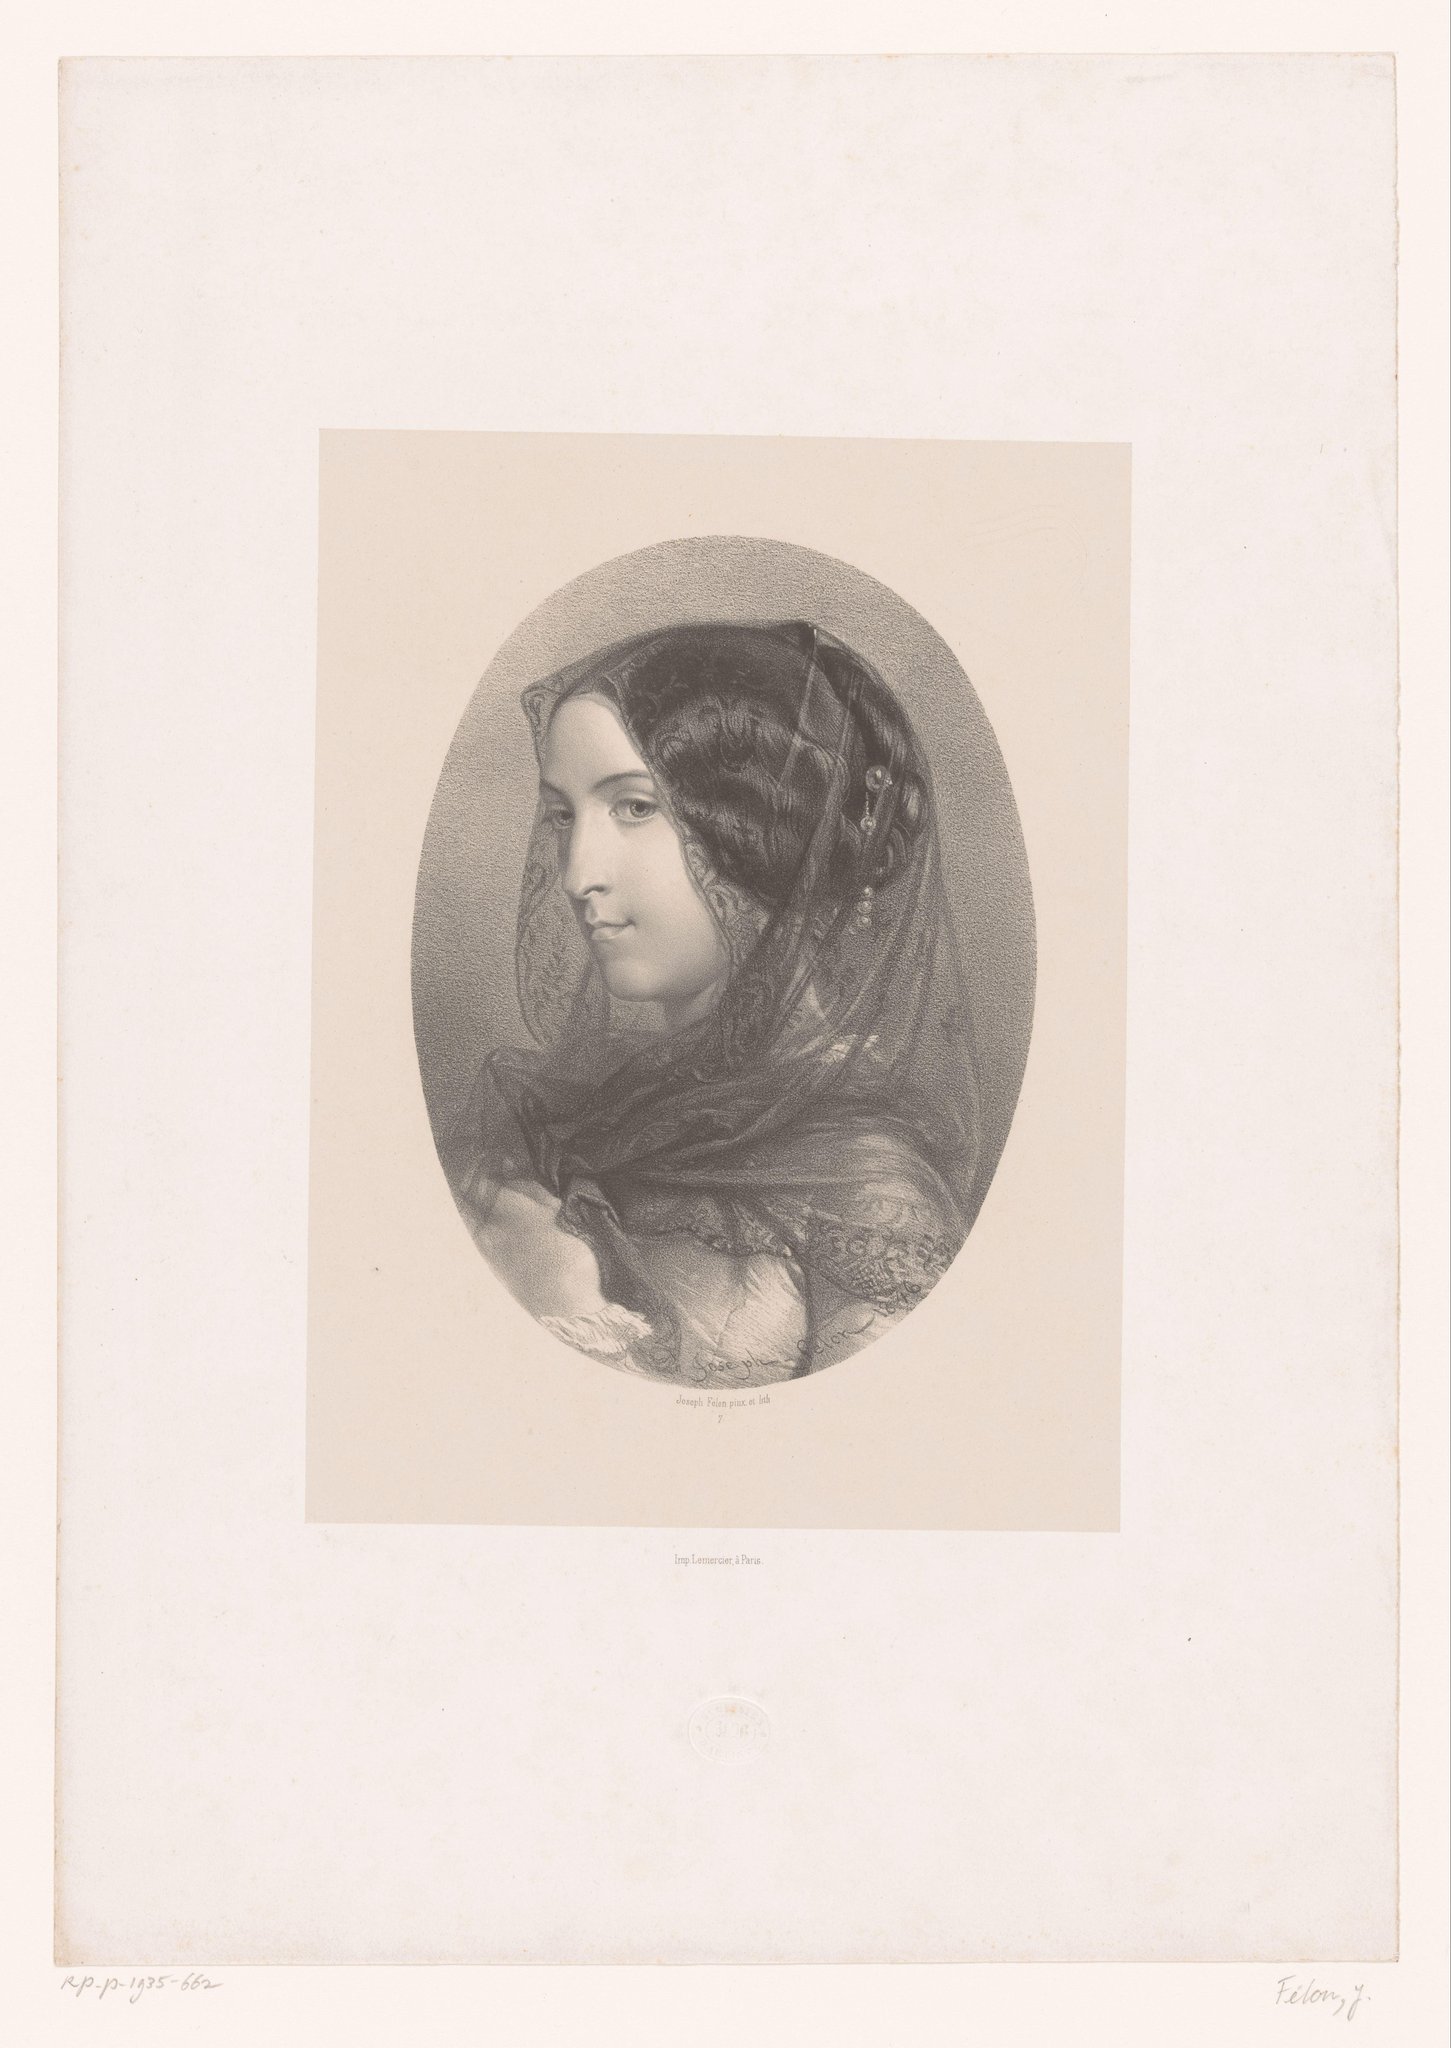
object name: print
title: Hoofd van een vrouw met sluier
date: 1846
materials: paper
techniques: lithograph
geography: paris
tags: head turned to the left - aa - female human figure, veil, anonymous historical person portrayed - bb - woman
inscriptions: check stamp: ‘Souvenirs d'ariste’, collector's mark: Lugt 2228a